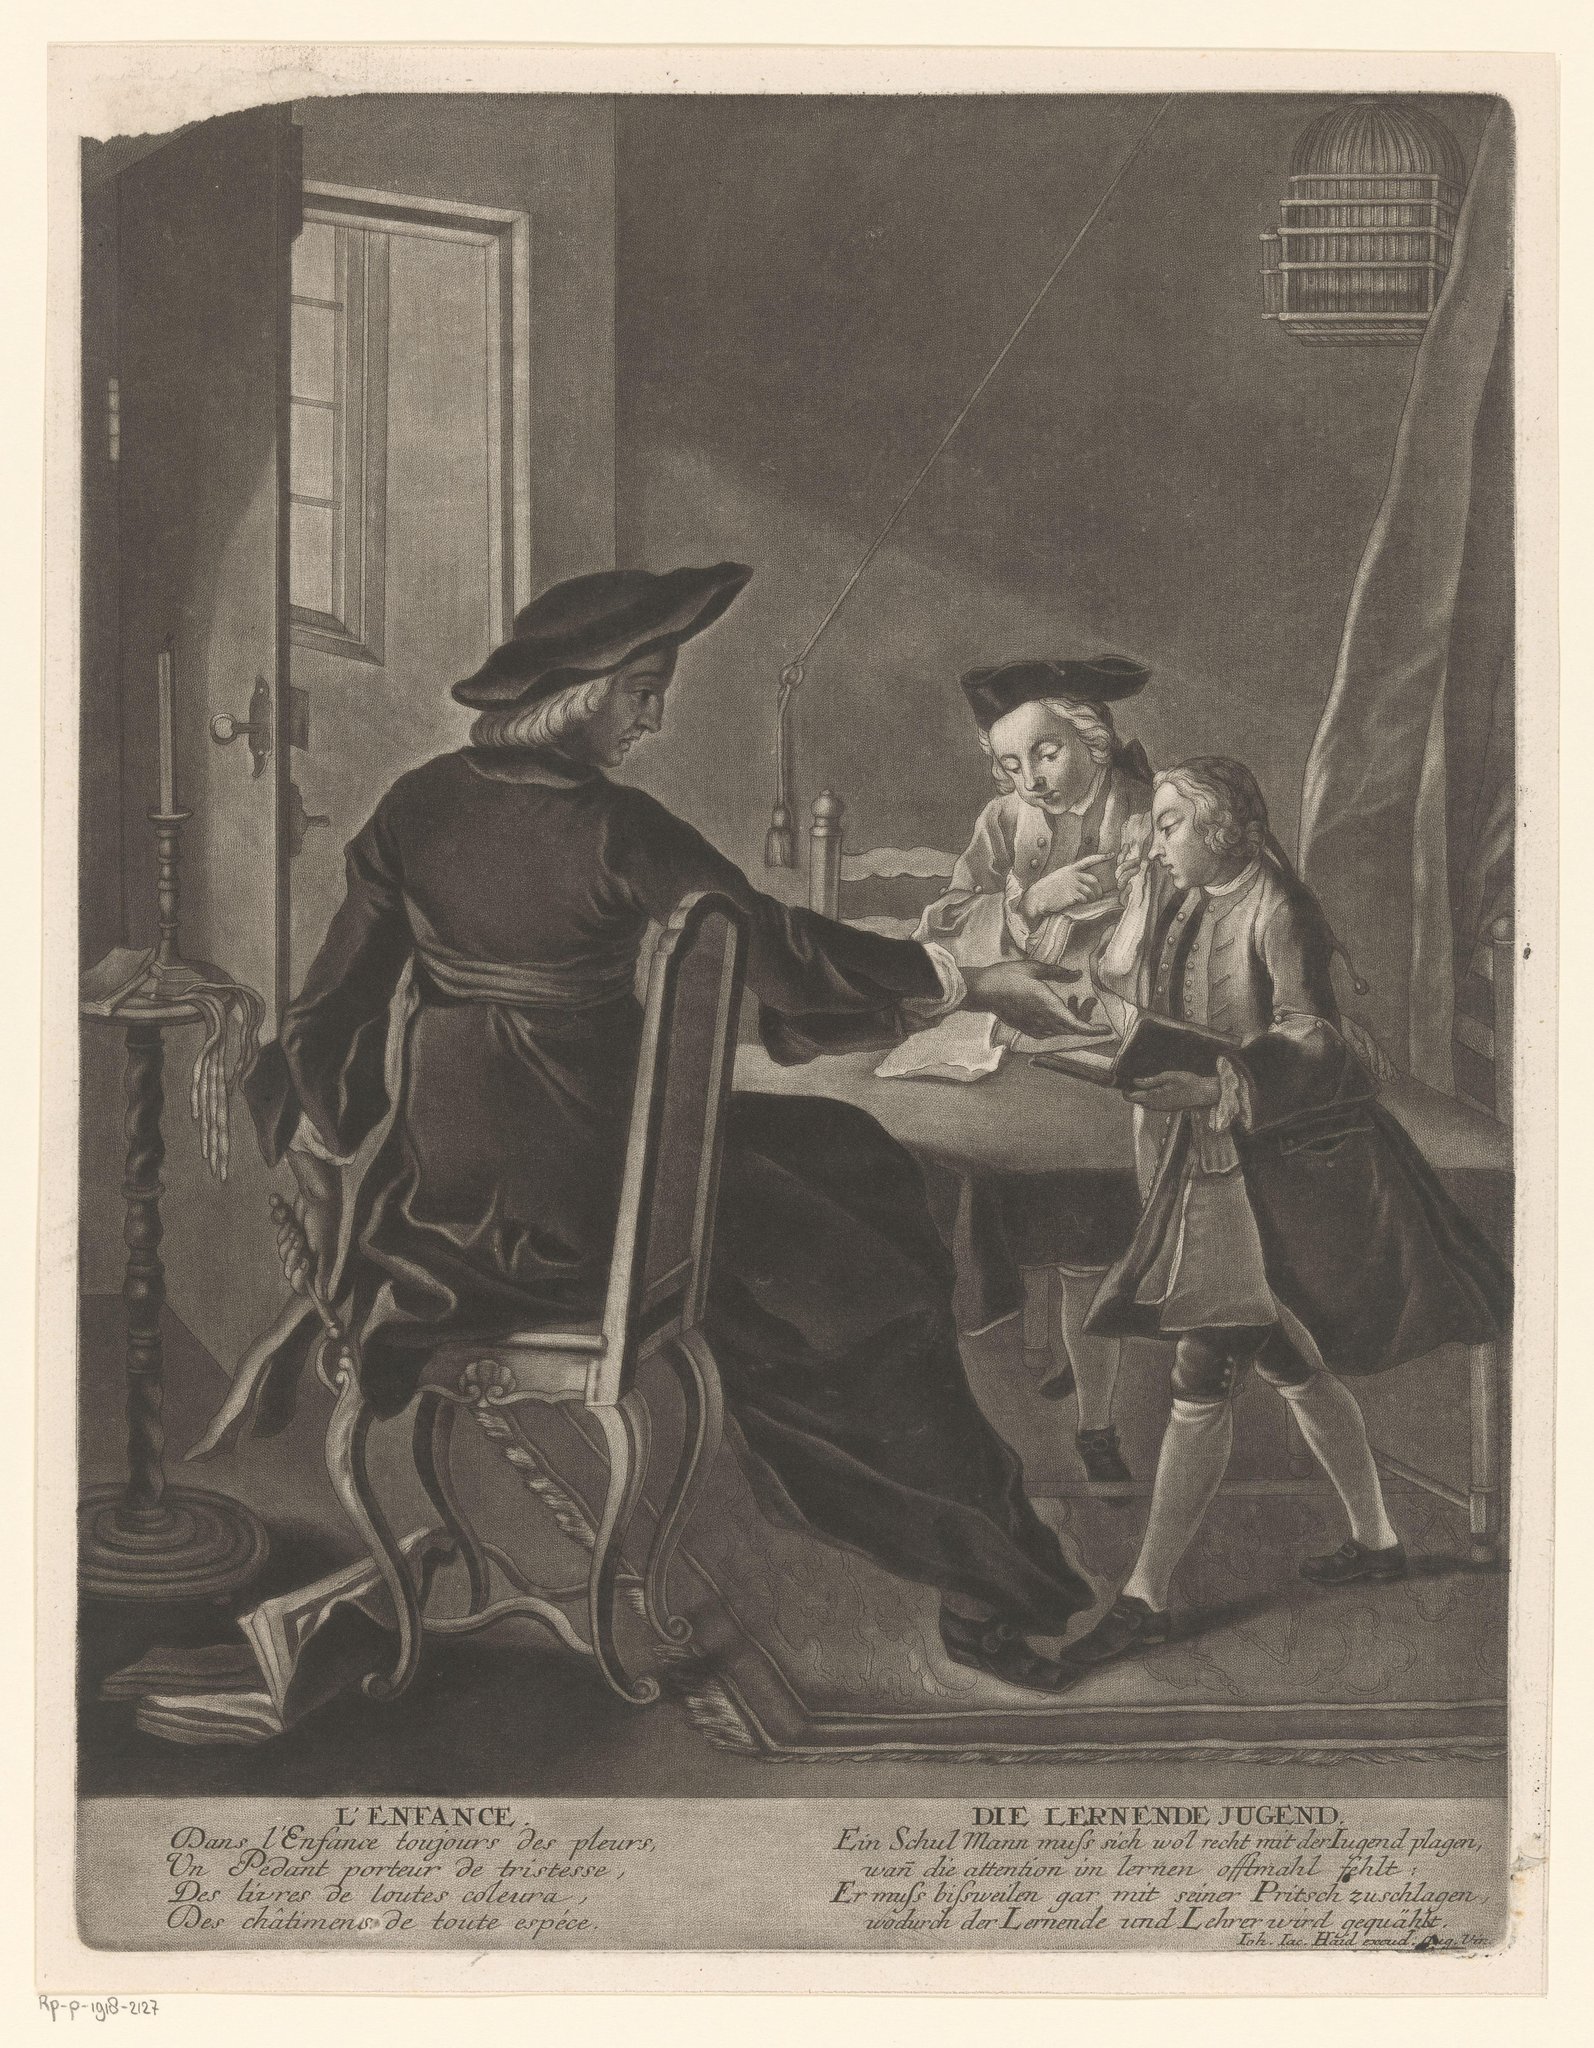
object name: print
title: L'Enfance / Die lernende Jugend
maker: johann jacob haid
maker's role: print maker, publisher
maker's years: 1704-1767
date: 1714-1767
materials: paper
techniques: etching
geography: augsburg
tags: teacher and pupil, education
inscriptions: collector's mark: Lugt 2233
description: Mogelijk naar origineel van de Franse schilder Chardin, Jeaurat of Jardin.